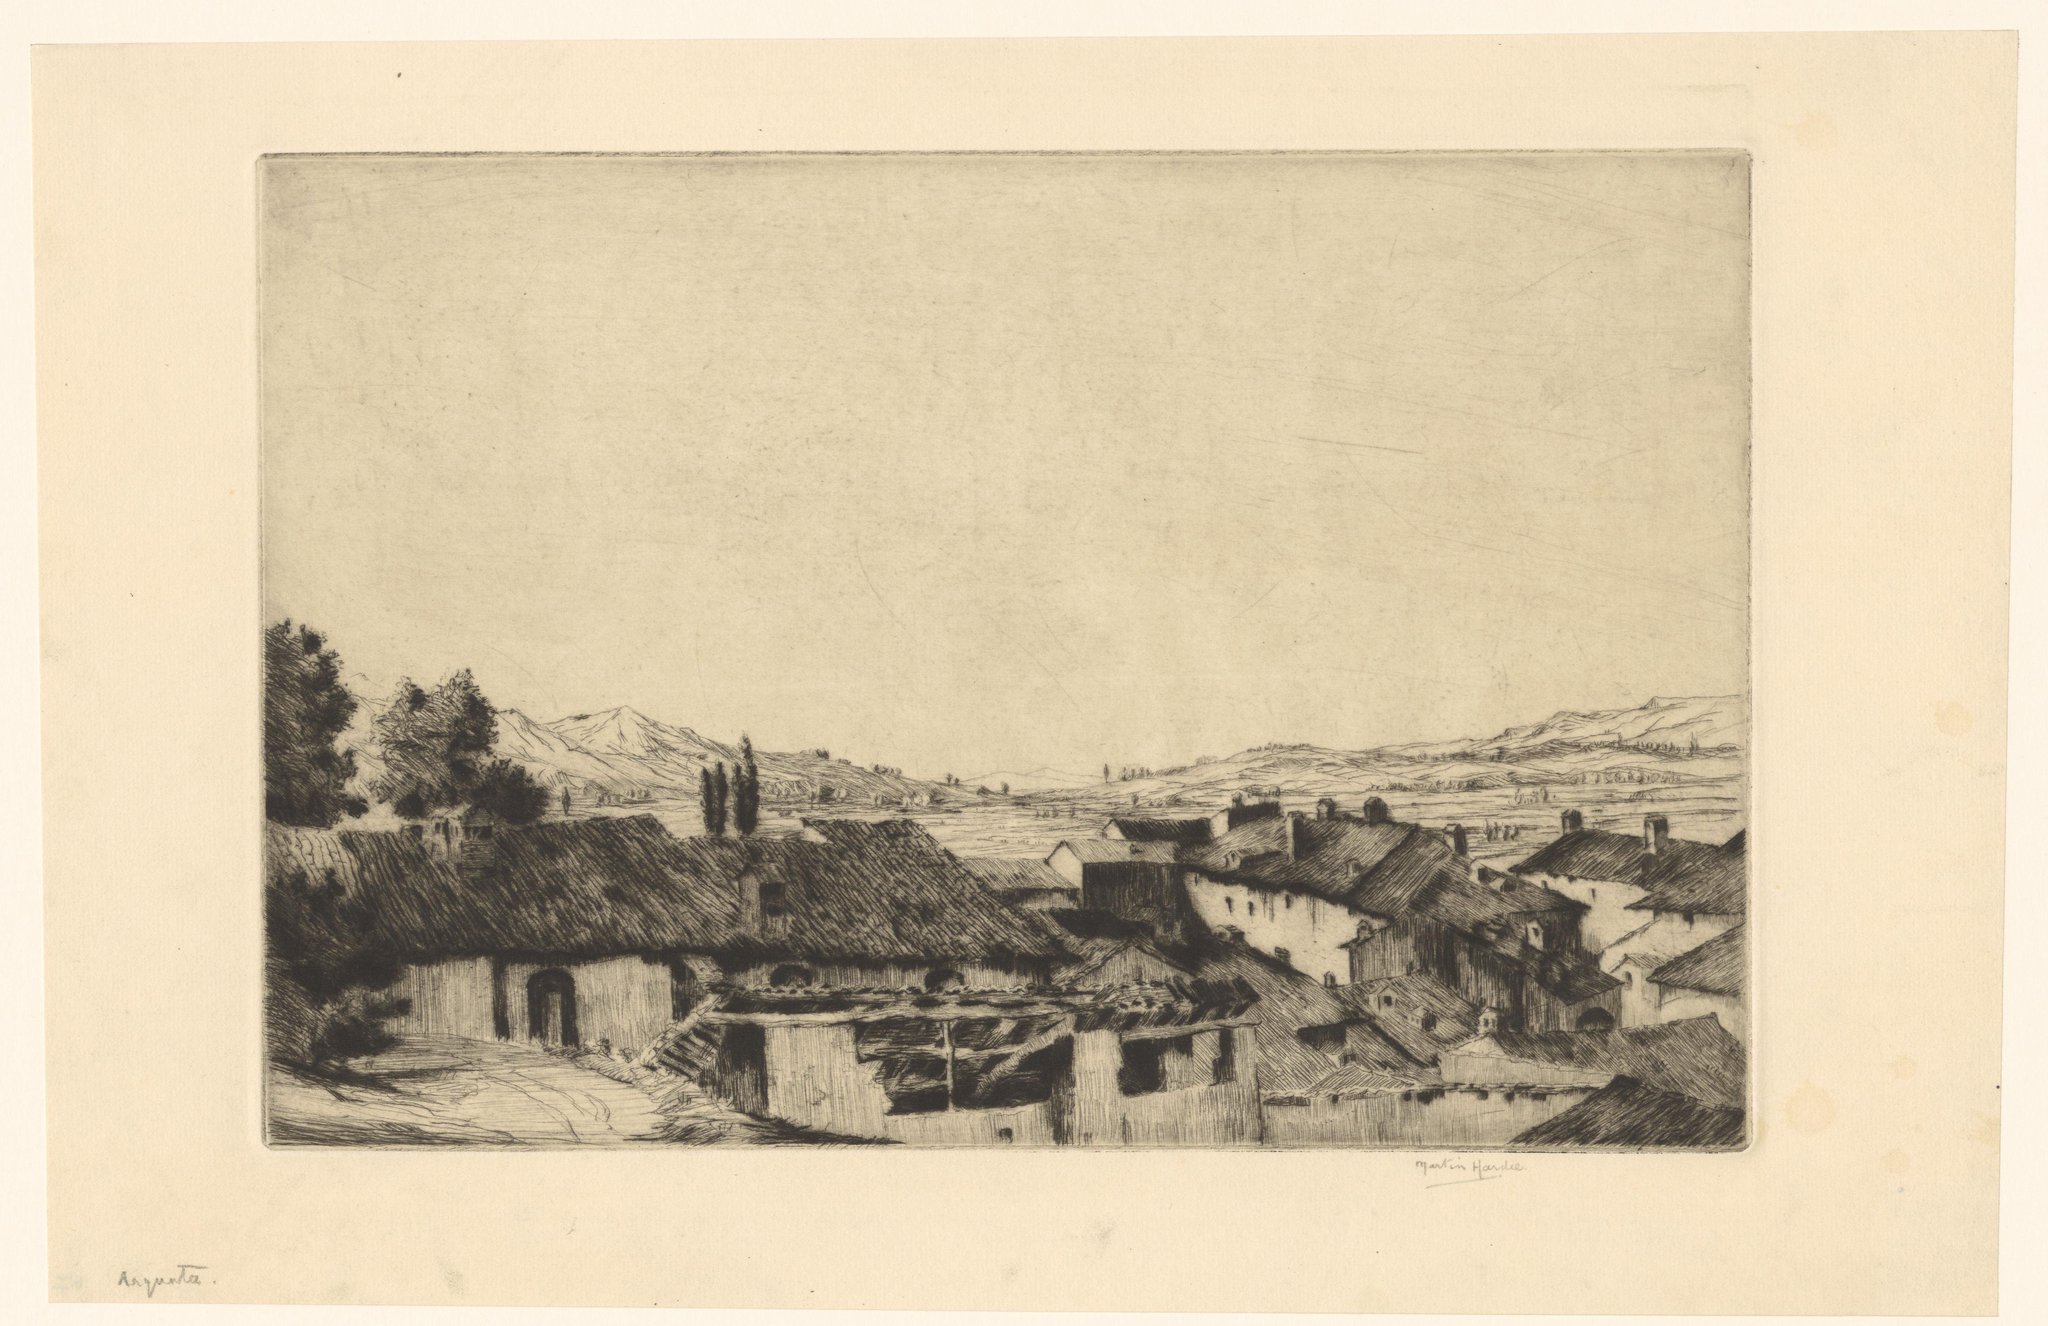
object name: print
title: Gezicht over de daken van Arquata Scrivia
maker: martin hardie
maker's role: print maker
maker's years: 1875-1952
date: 1918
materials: paper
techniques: drypoint, etching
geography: arquata scrivia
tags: low hill country, city-view in general; 'veduta'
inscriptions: collector's mark: Lugt 2228, collector's mark: Lugt 2760, annotation: ‘Martin Hardie’